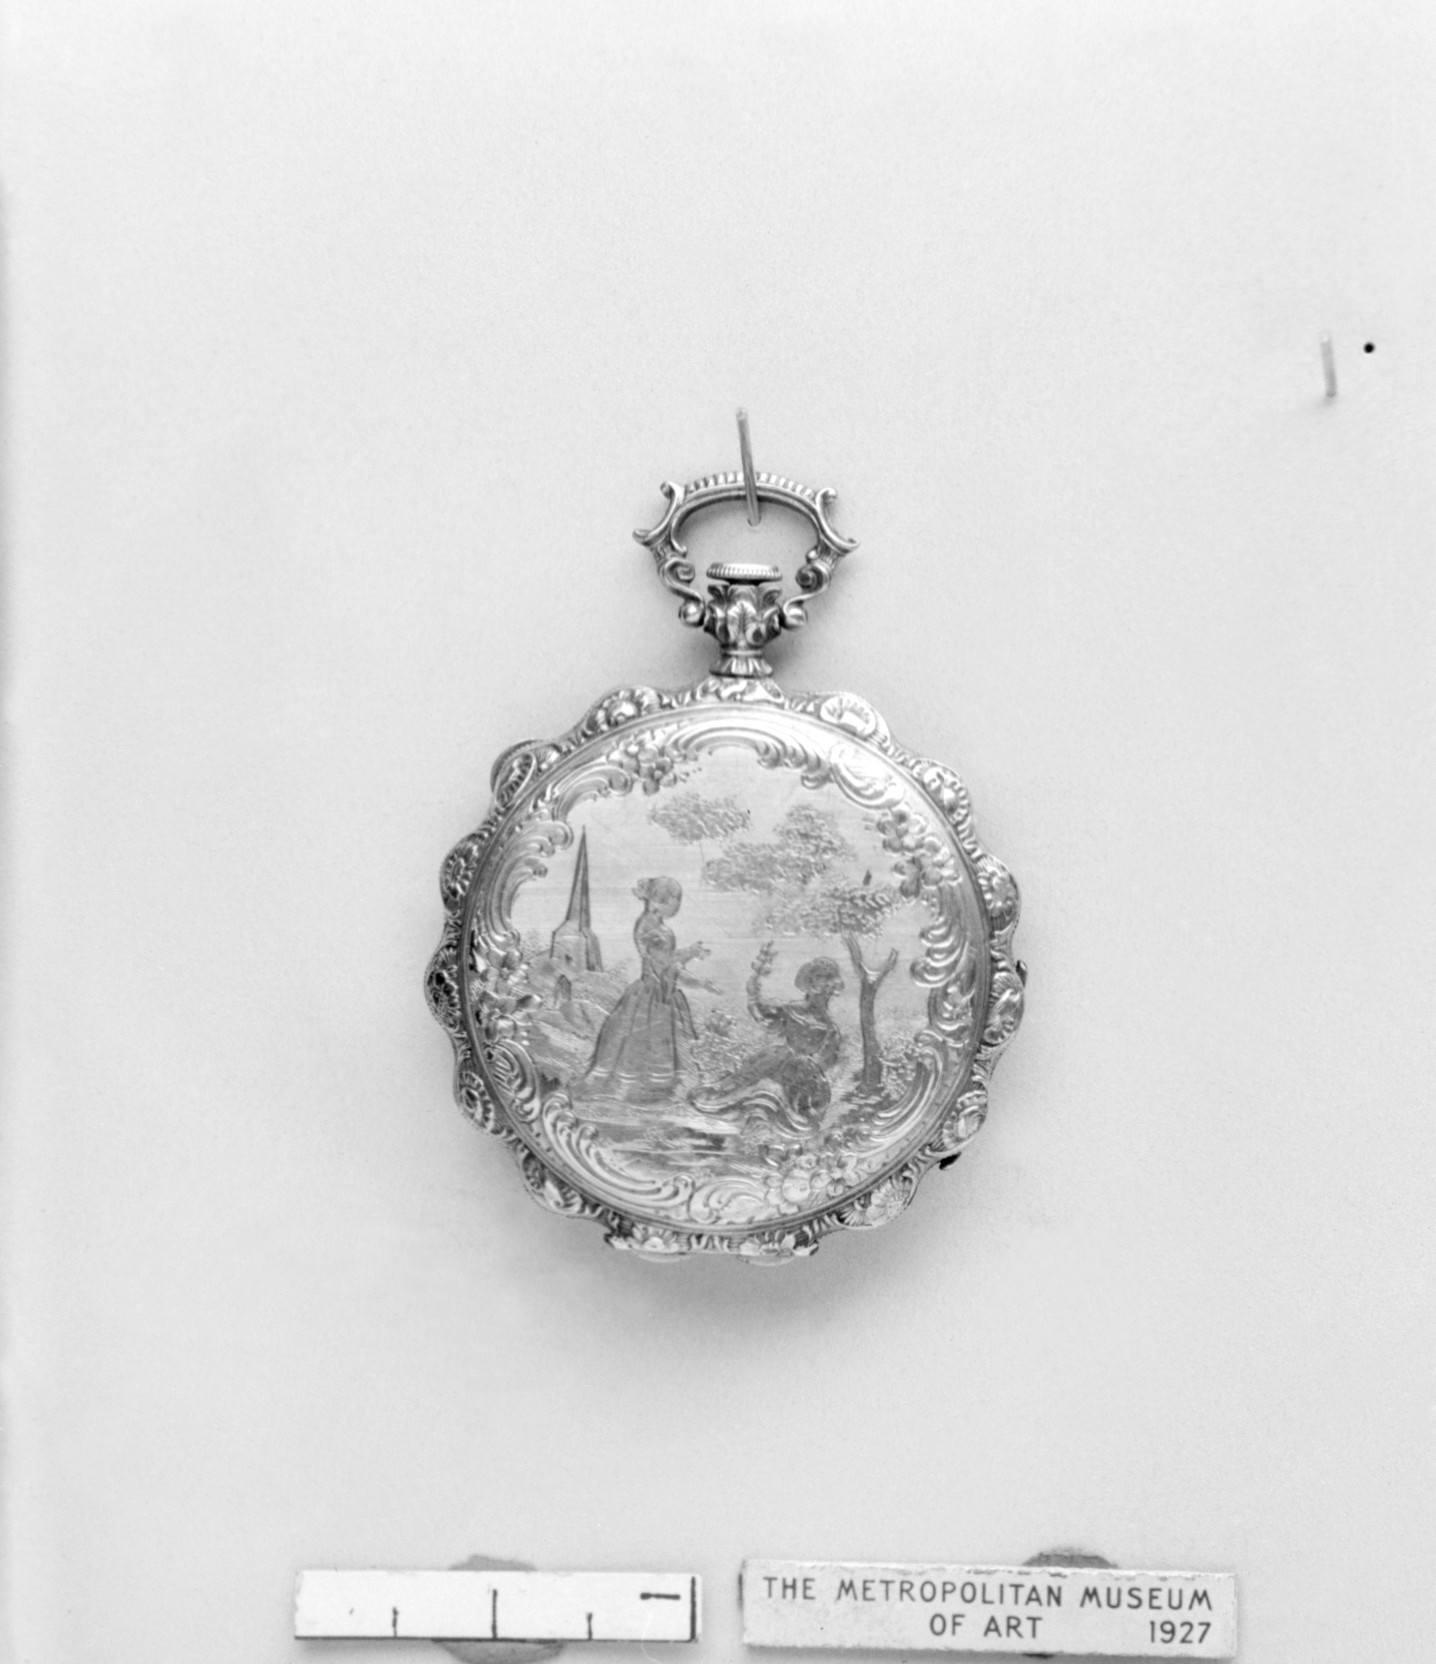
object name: watch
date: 1835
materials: gold, silver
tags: women,trees